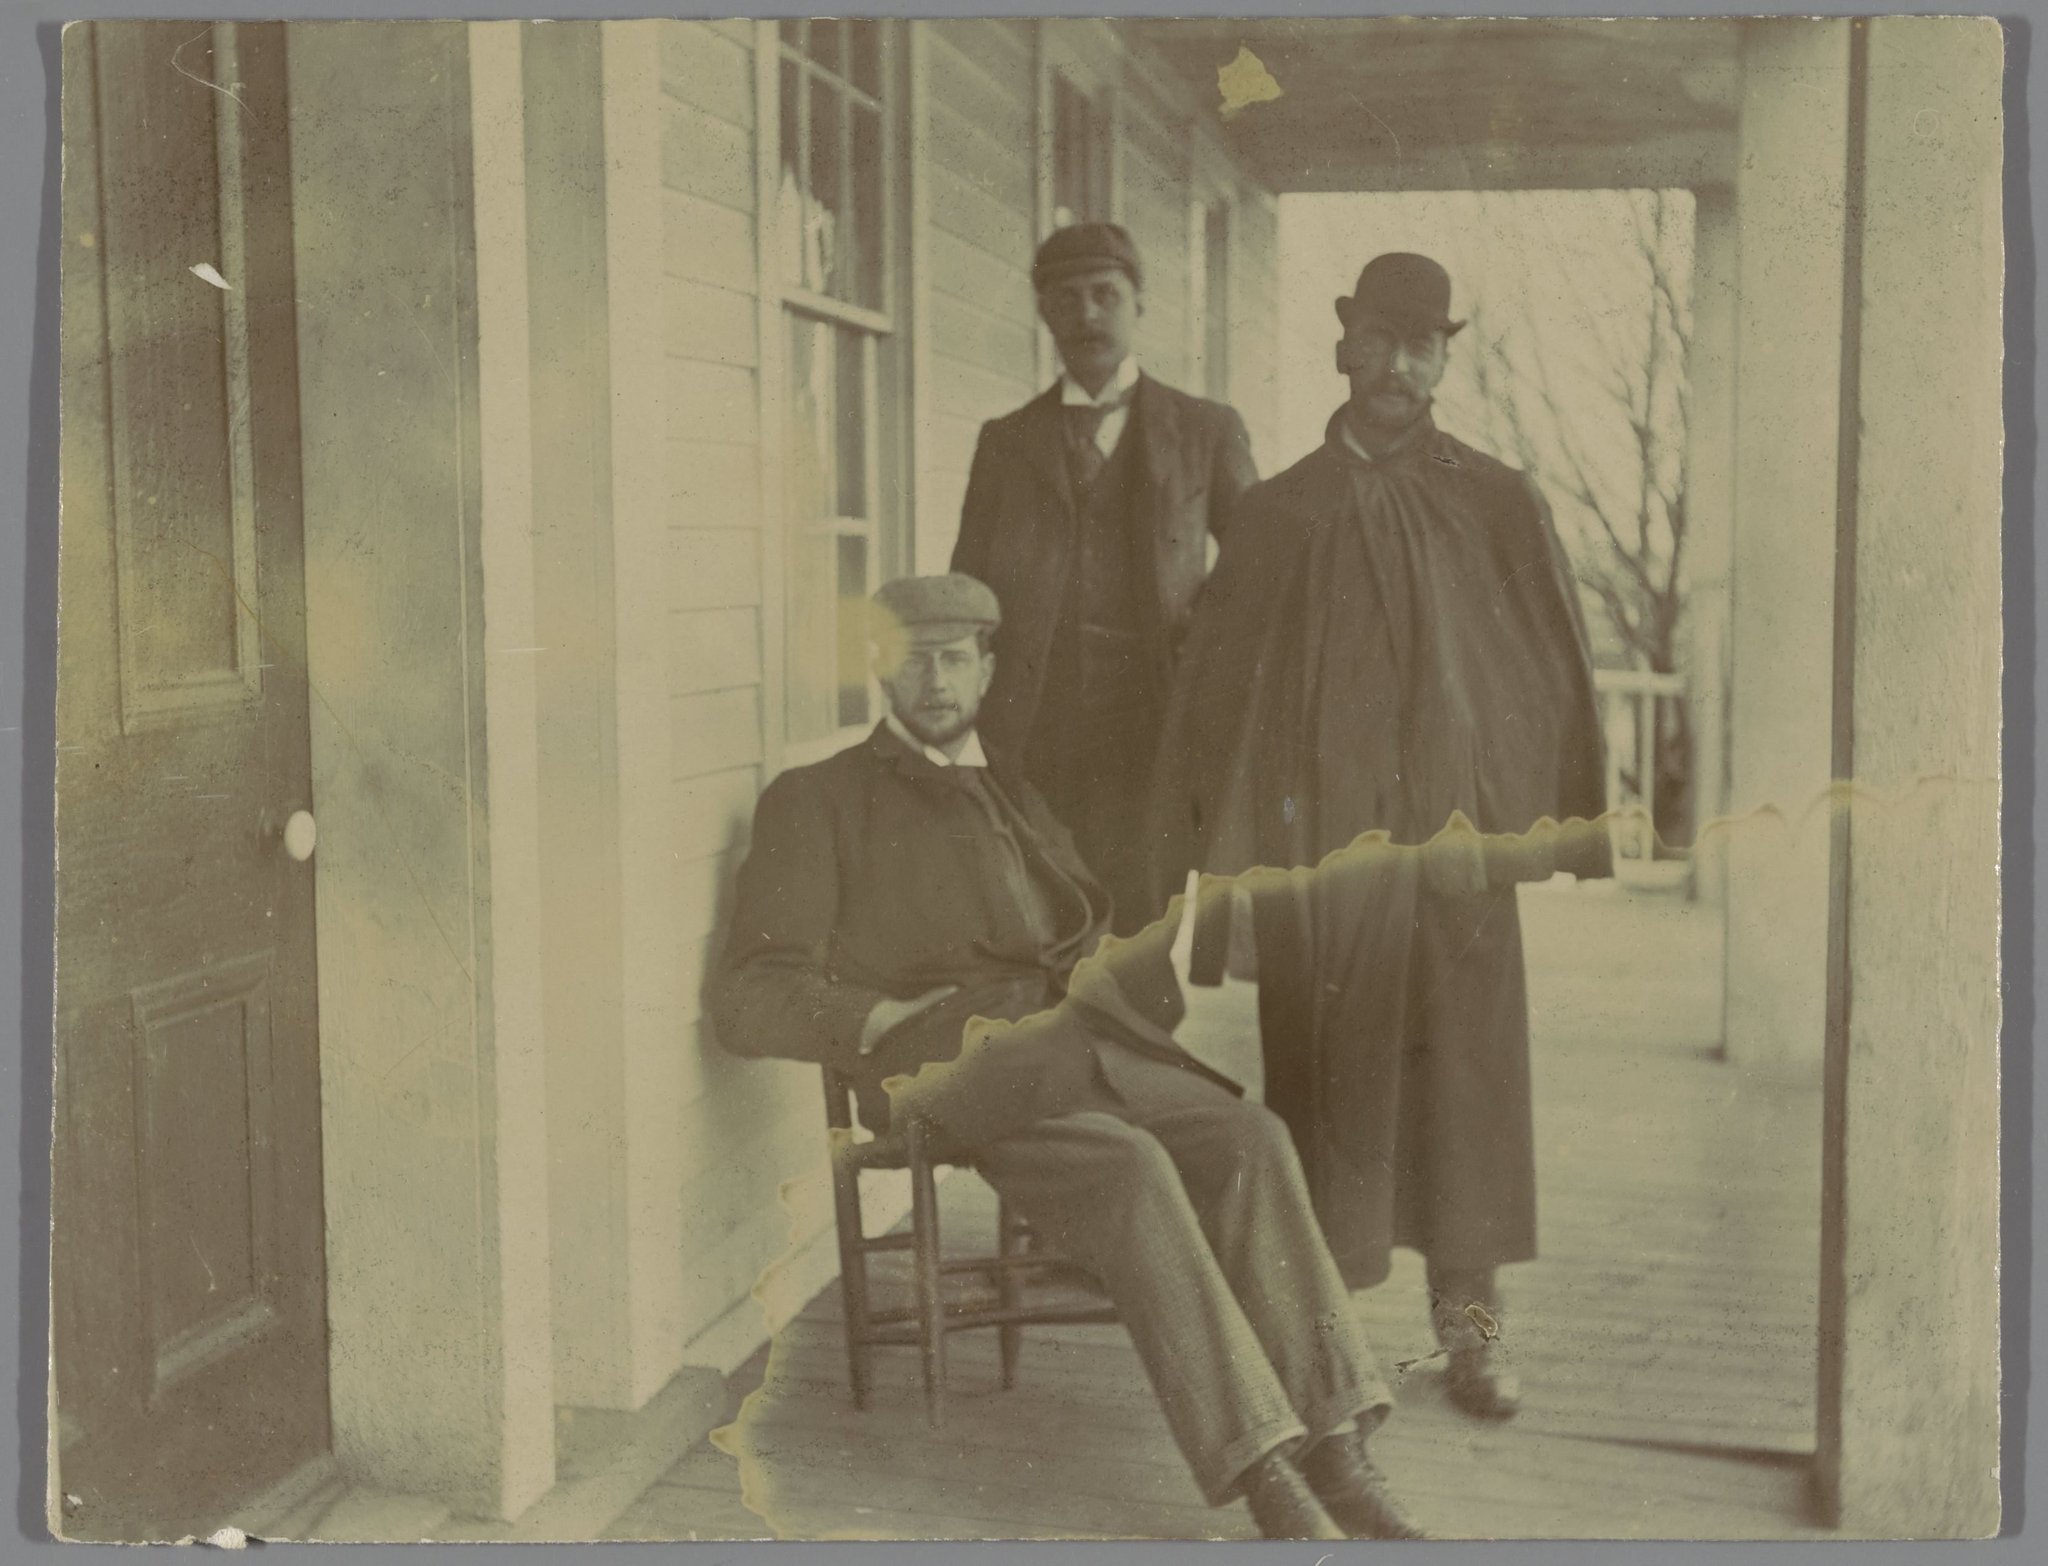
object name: photograph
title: Drie mannen in reiskleding op een veranda in Queenston, Canada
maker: Anonymous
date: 1890-1910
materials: paper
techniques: gelatin silver print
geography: queenston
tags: 'en route', traveller under way